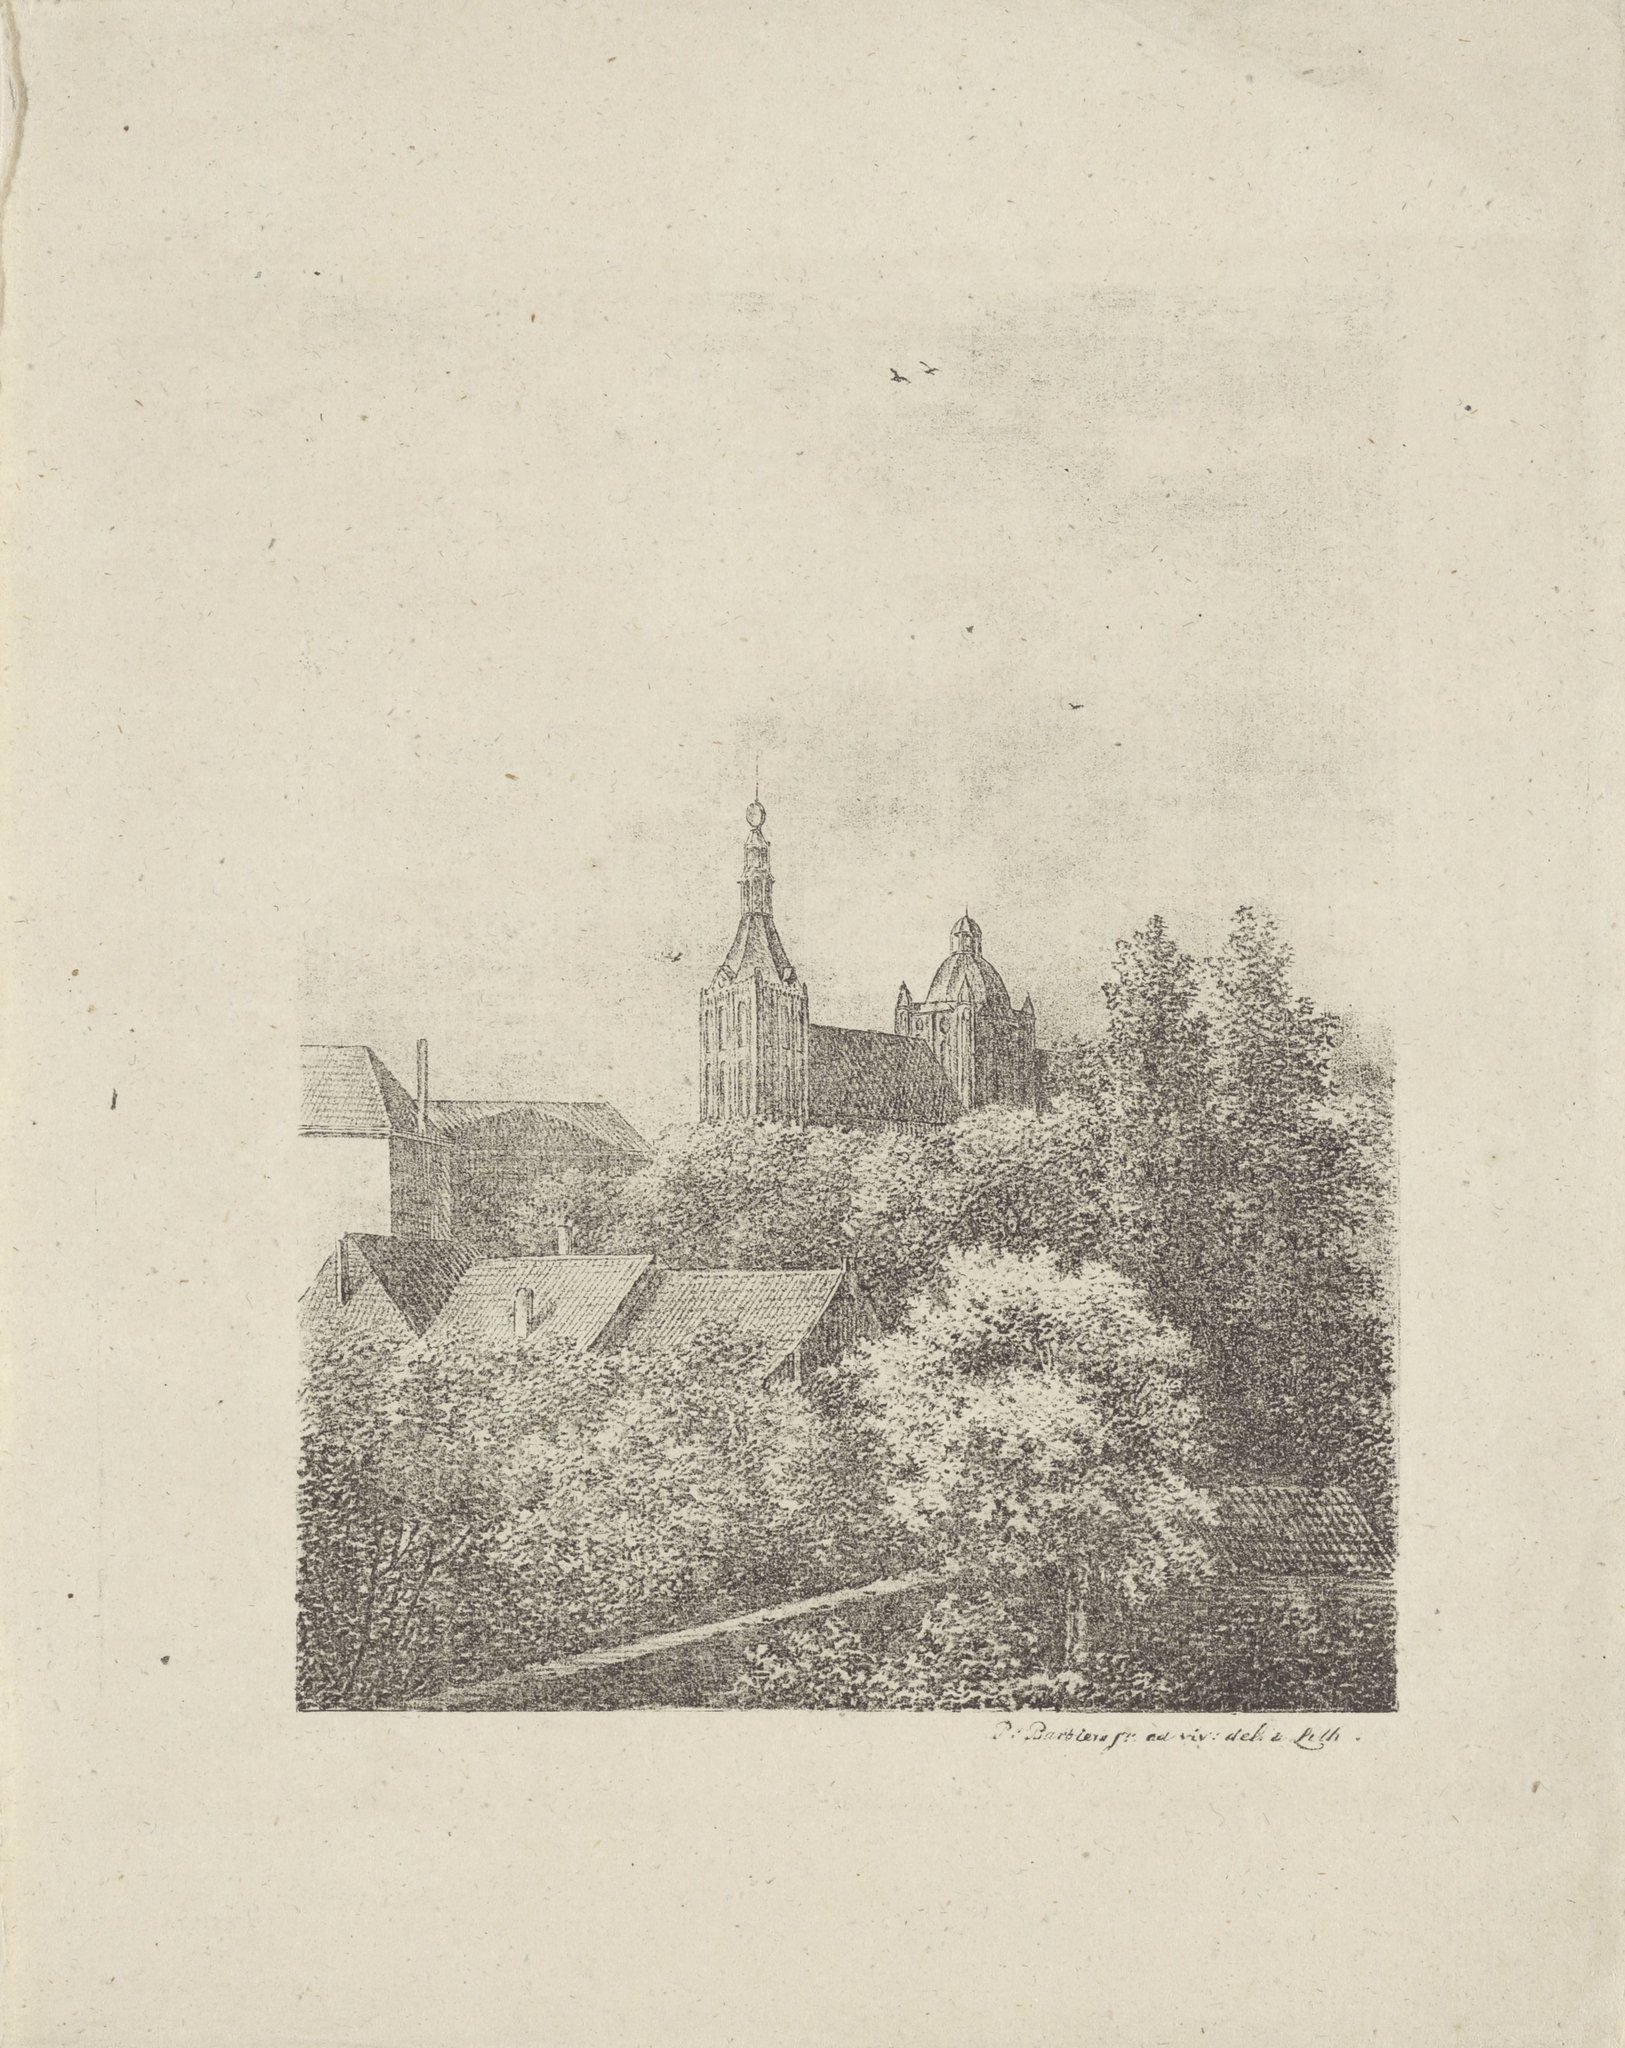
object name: print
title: Gezicht op 's-Hertogenbosch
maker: pieter barbiers (iv)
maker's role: painter, print maker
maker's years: 1798-1848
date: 1808-1848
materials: paper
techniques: lithograph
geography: netherlands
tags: trees, roof (of house or building), church (exterior), den bosch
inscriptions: collector's mark: Lugt 2228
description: Achter boomtoppen en daken van huizen is de Sint Jan zichtbaar.